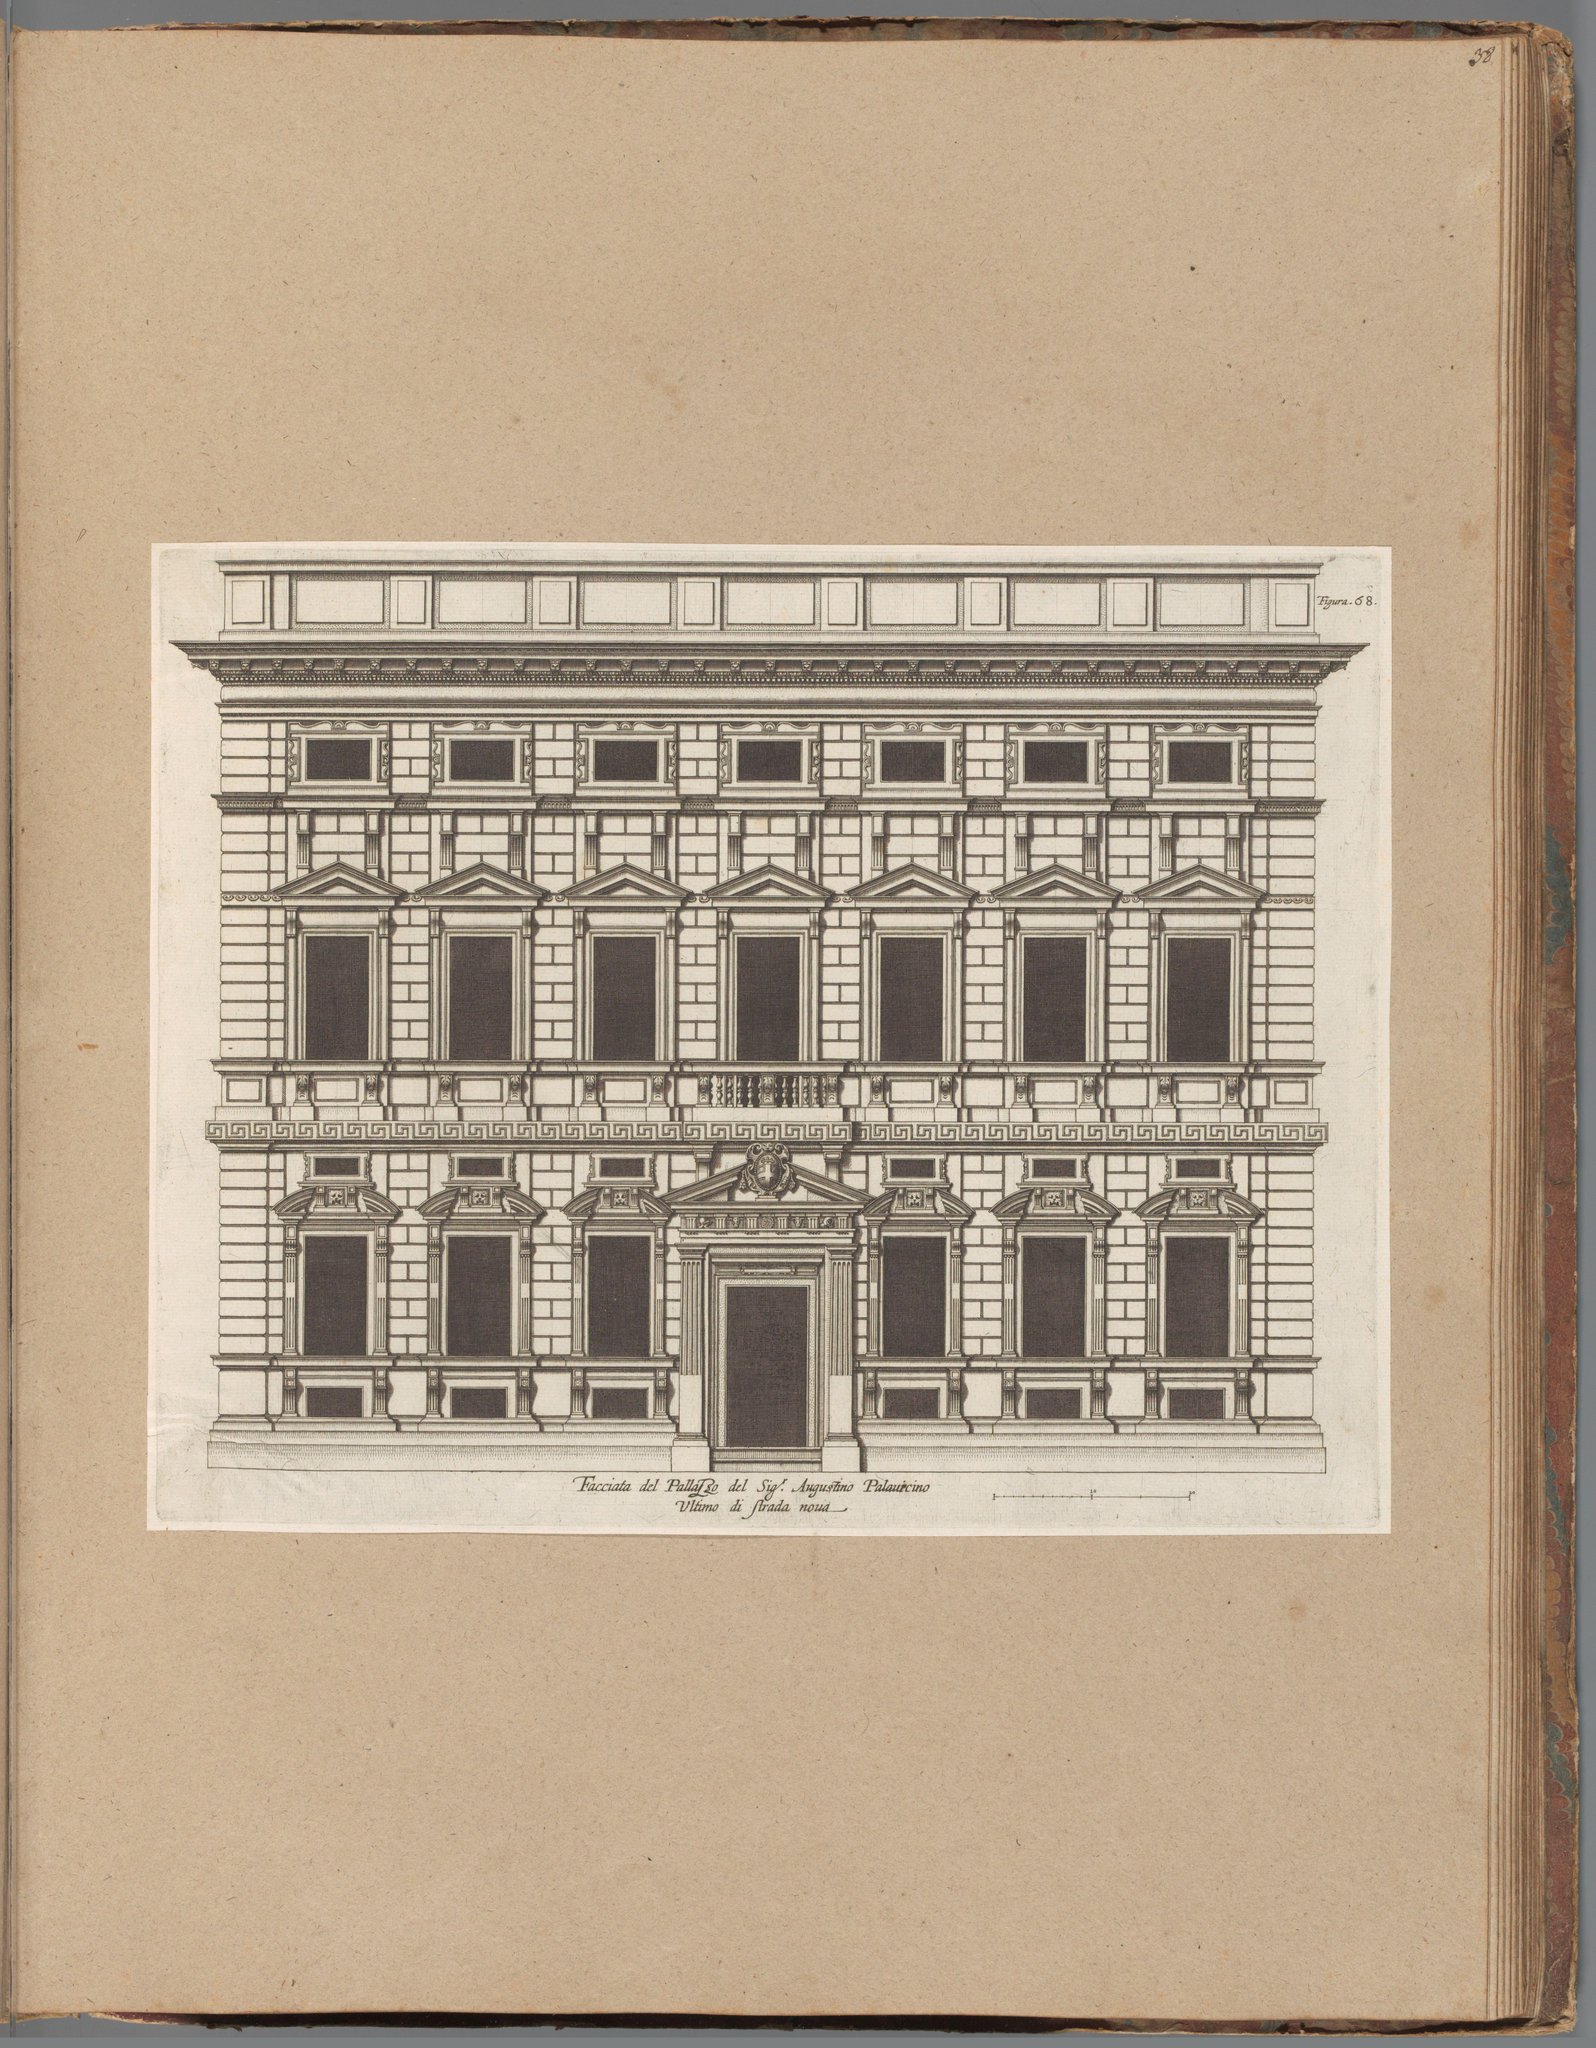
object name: album leaf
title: Facciata del Palazzo del Sigr. Augustino Palavicino / Ultimo di strada nova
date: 1622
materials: paper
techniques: engraving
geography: antwerp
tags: hôtel, i.e. small palace in city, façade (of house or building), exterior ~ architectural design or model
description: Deze prent maakt deel uit van een album.